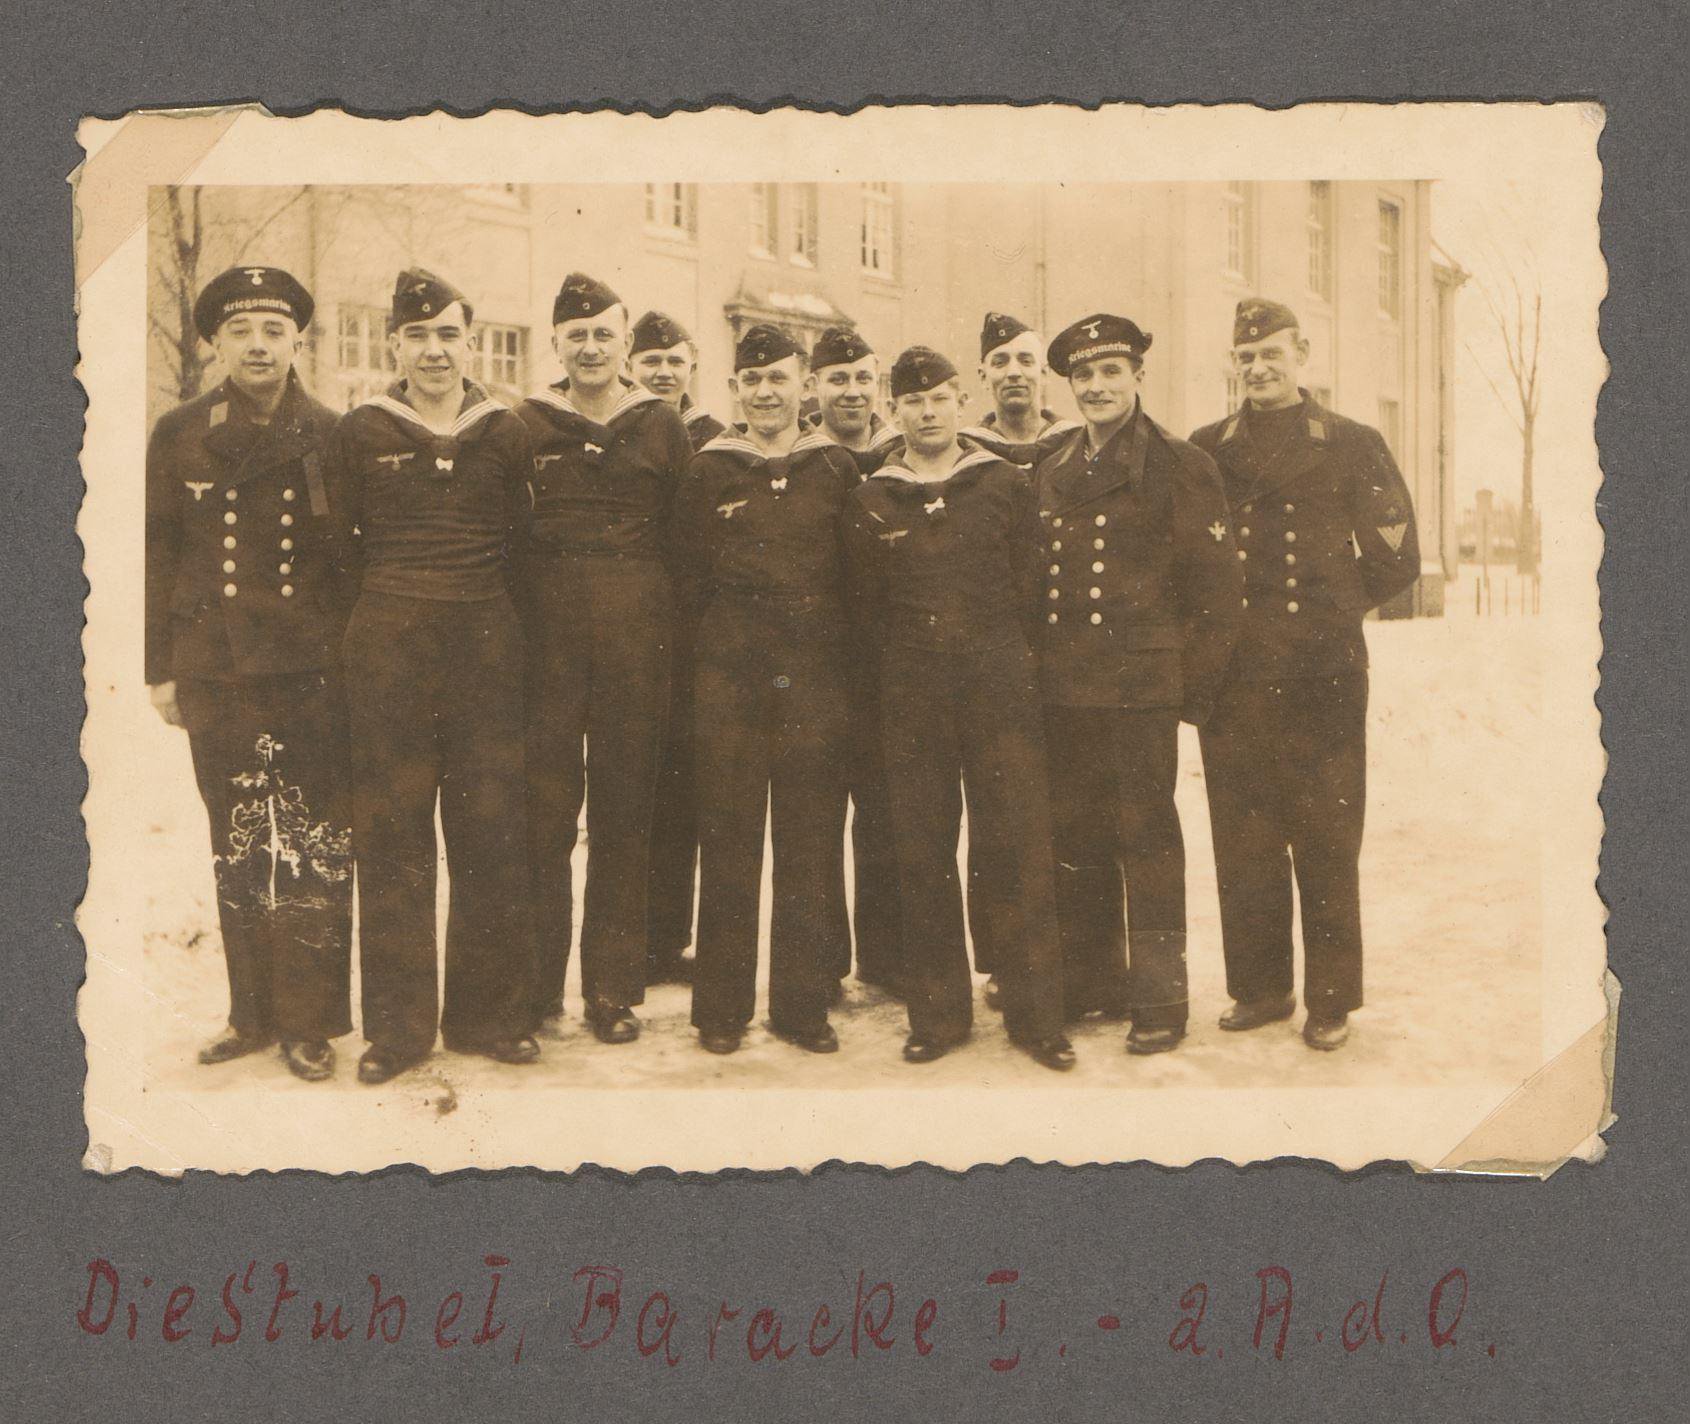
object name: photograph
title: Groepsportret van militairen in uniform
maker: Anonymous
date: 1941-1945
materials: paper, photographic support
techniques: gelatin silver print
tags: heinrich clausen, the company, the unit, the troop ~ military service, adult man, historical persons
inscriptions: annotation: ‘Die Stube, Baracke I-a. A. d. O.’